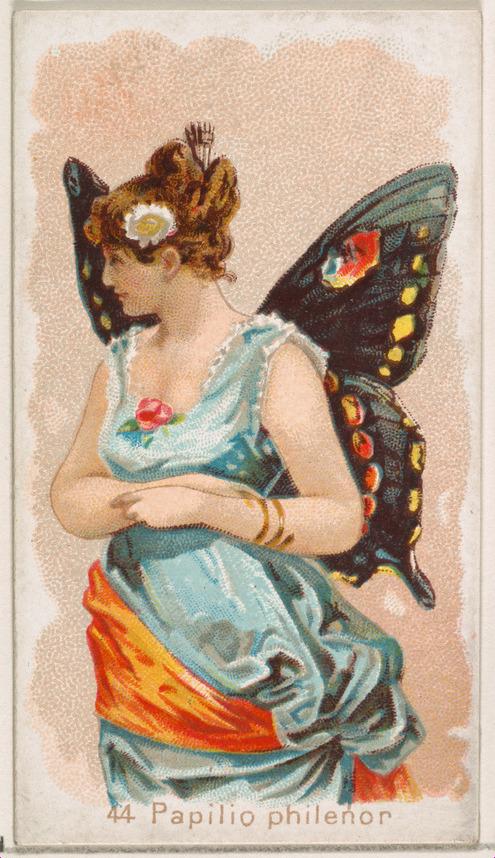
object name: print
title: Card 44, Papilio Philenor, from the Butterflies series (N183) issued by Wm. S. Kimball & Co.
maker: william s. kimball & company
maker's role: publisher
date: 1888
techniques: color lithograph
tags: profiles,women,butterflies